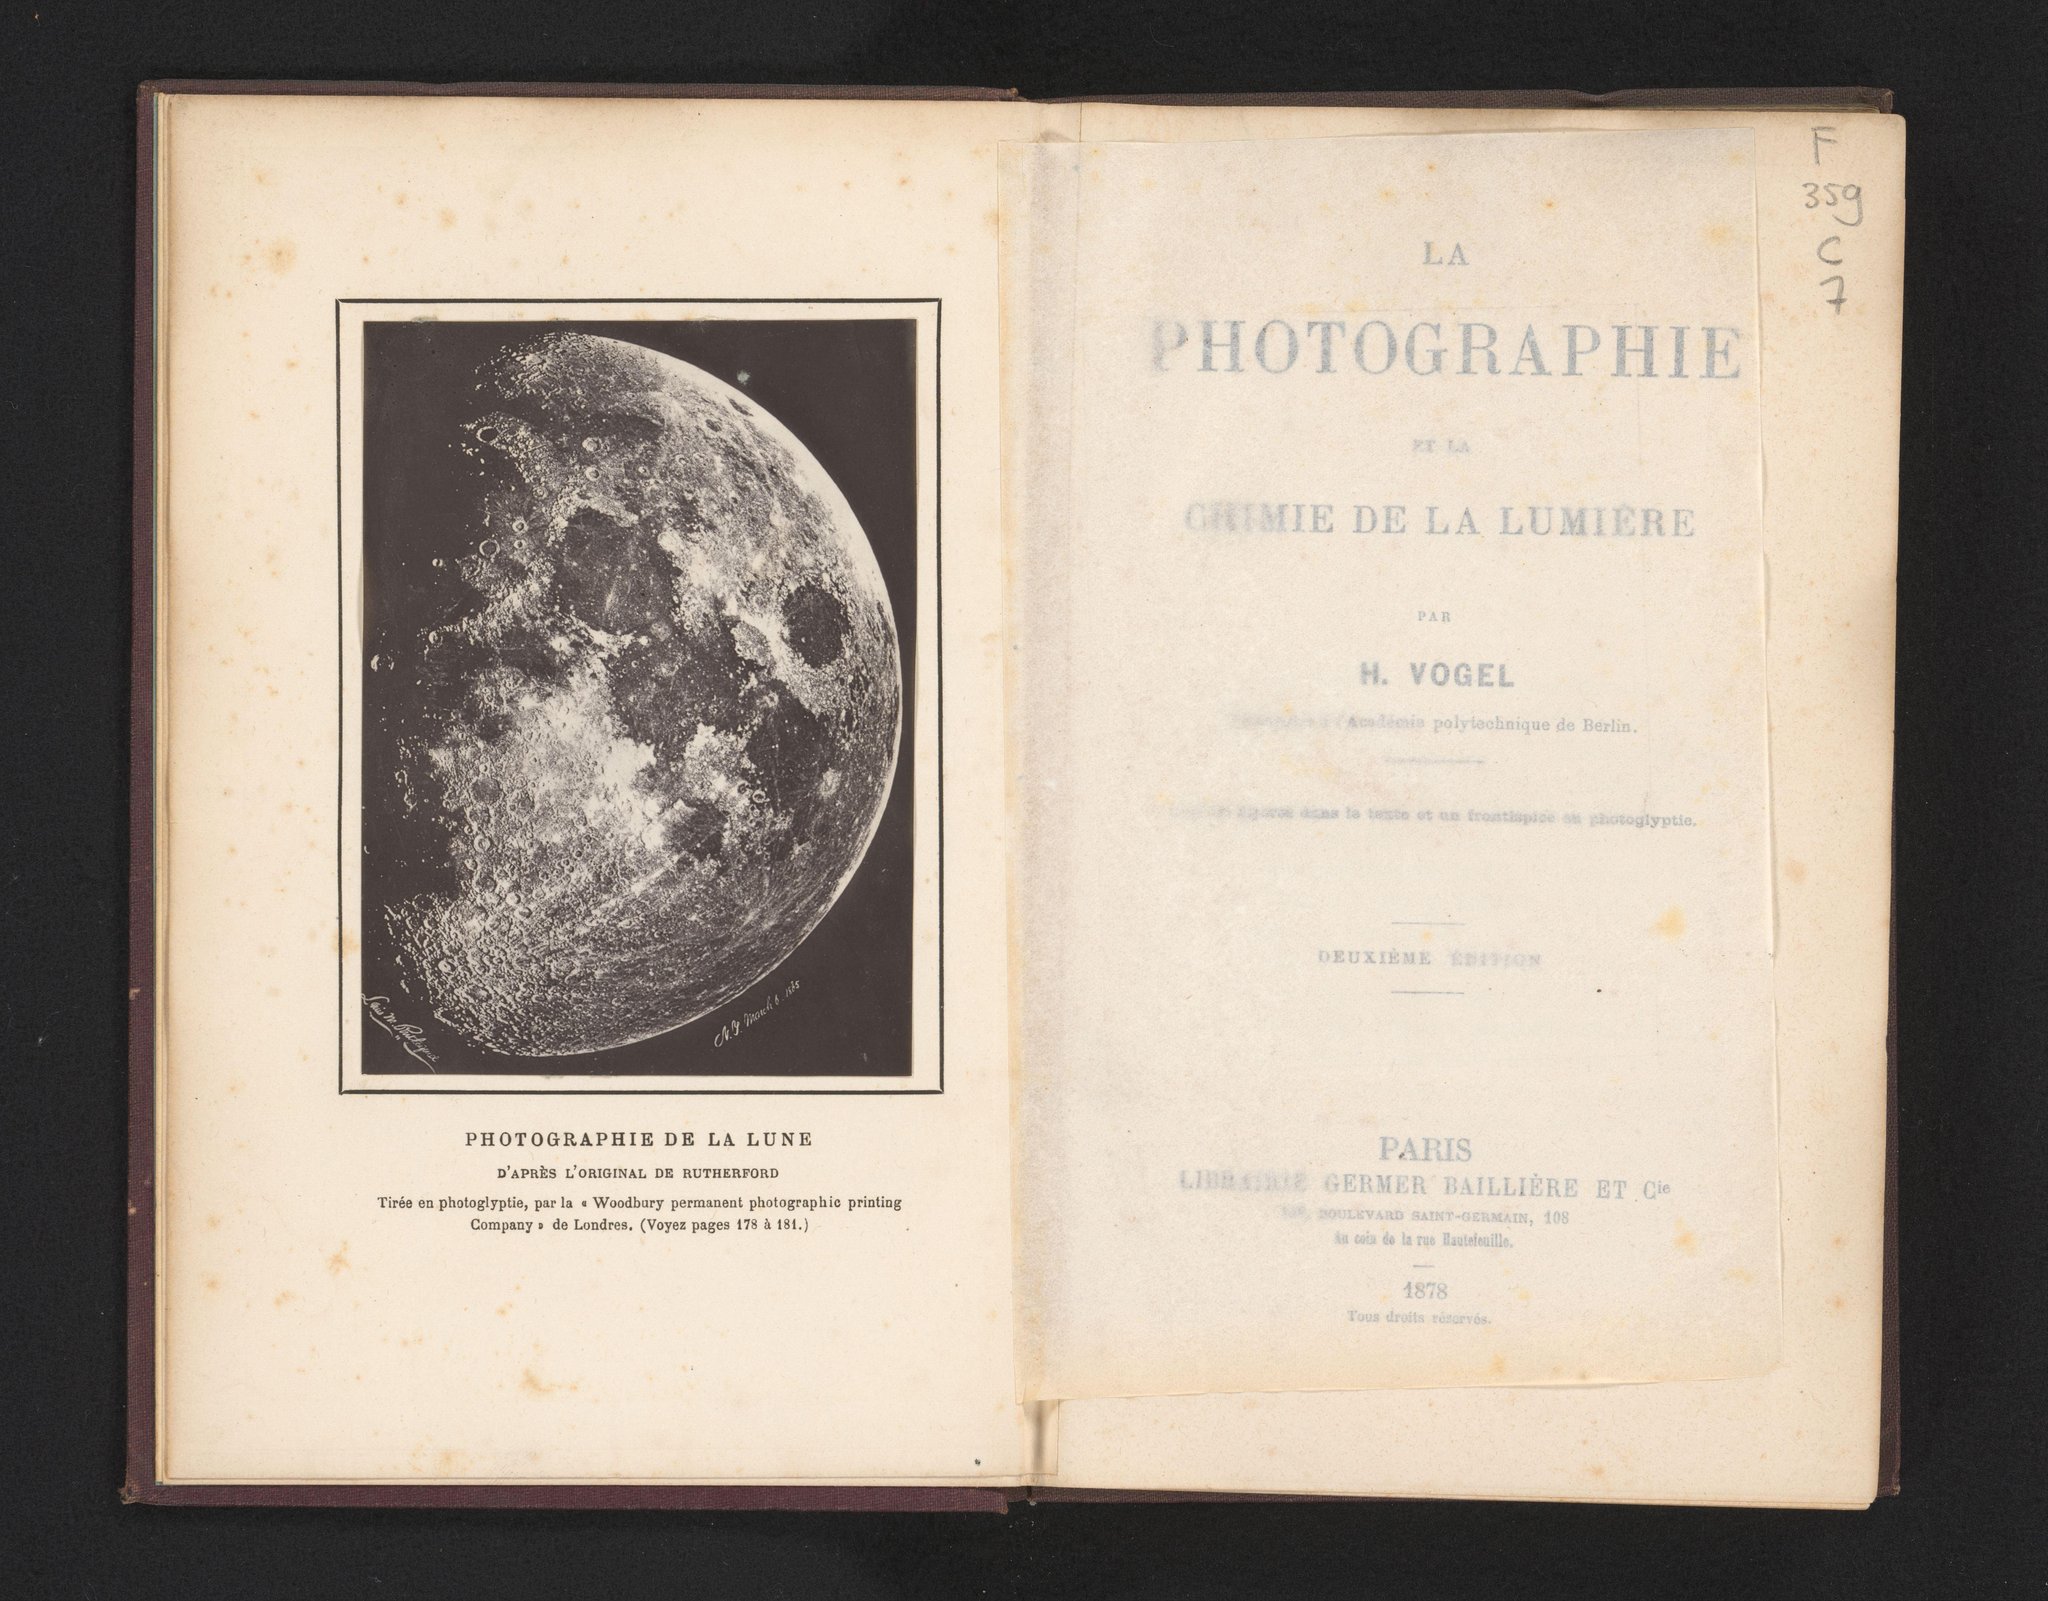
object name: photomechanical print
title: Gezicht op de maan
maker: lewis morris rutherfurd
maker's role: advocaat, astronoom, fotograaf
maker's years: 1816-1892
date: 1865-1878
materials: paper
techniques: woodburytype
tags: moon as celestial body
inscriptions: inscription: ‘Photographie de la lune’